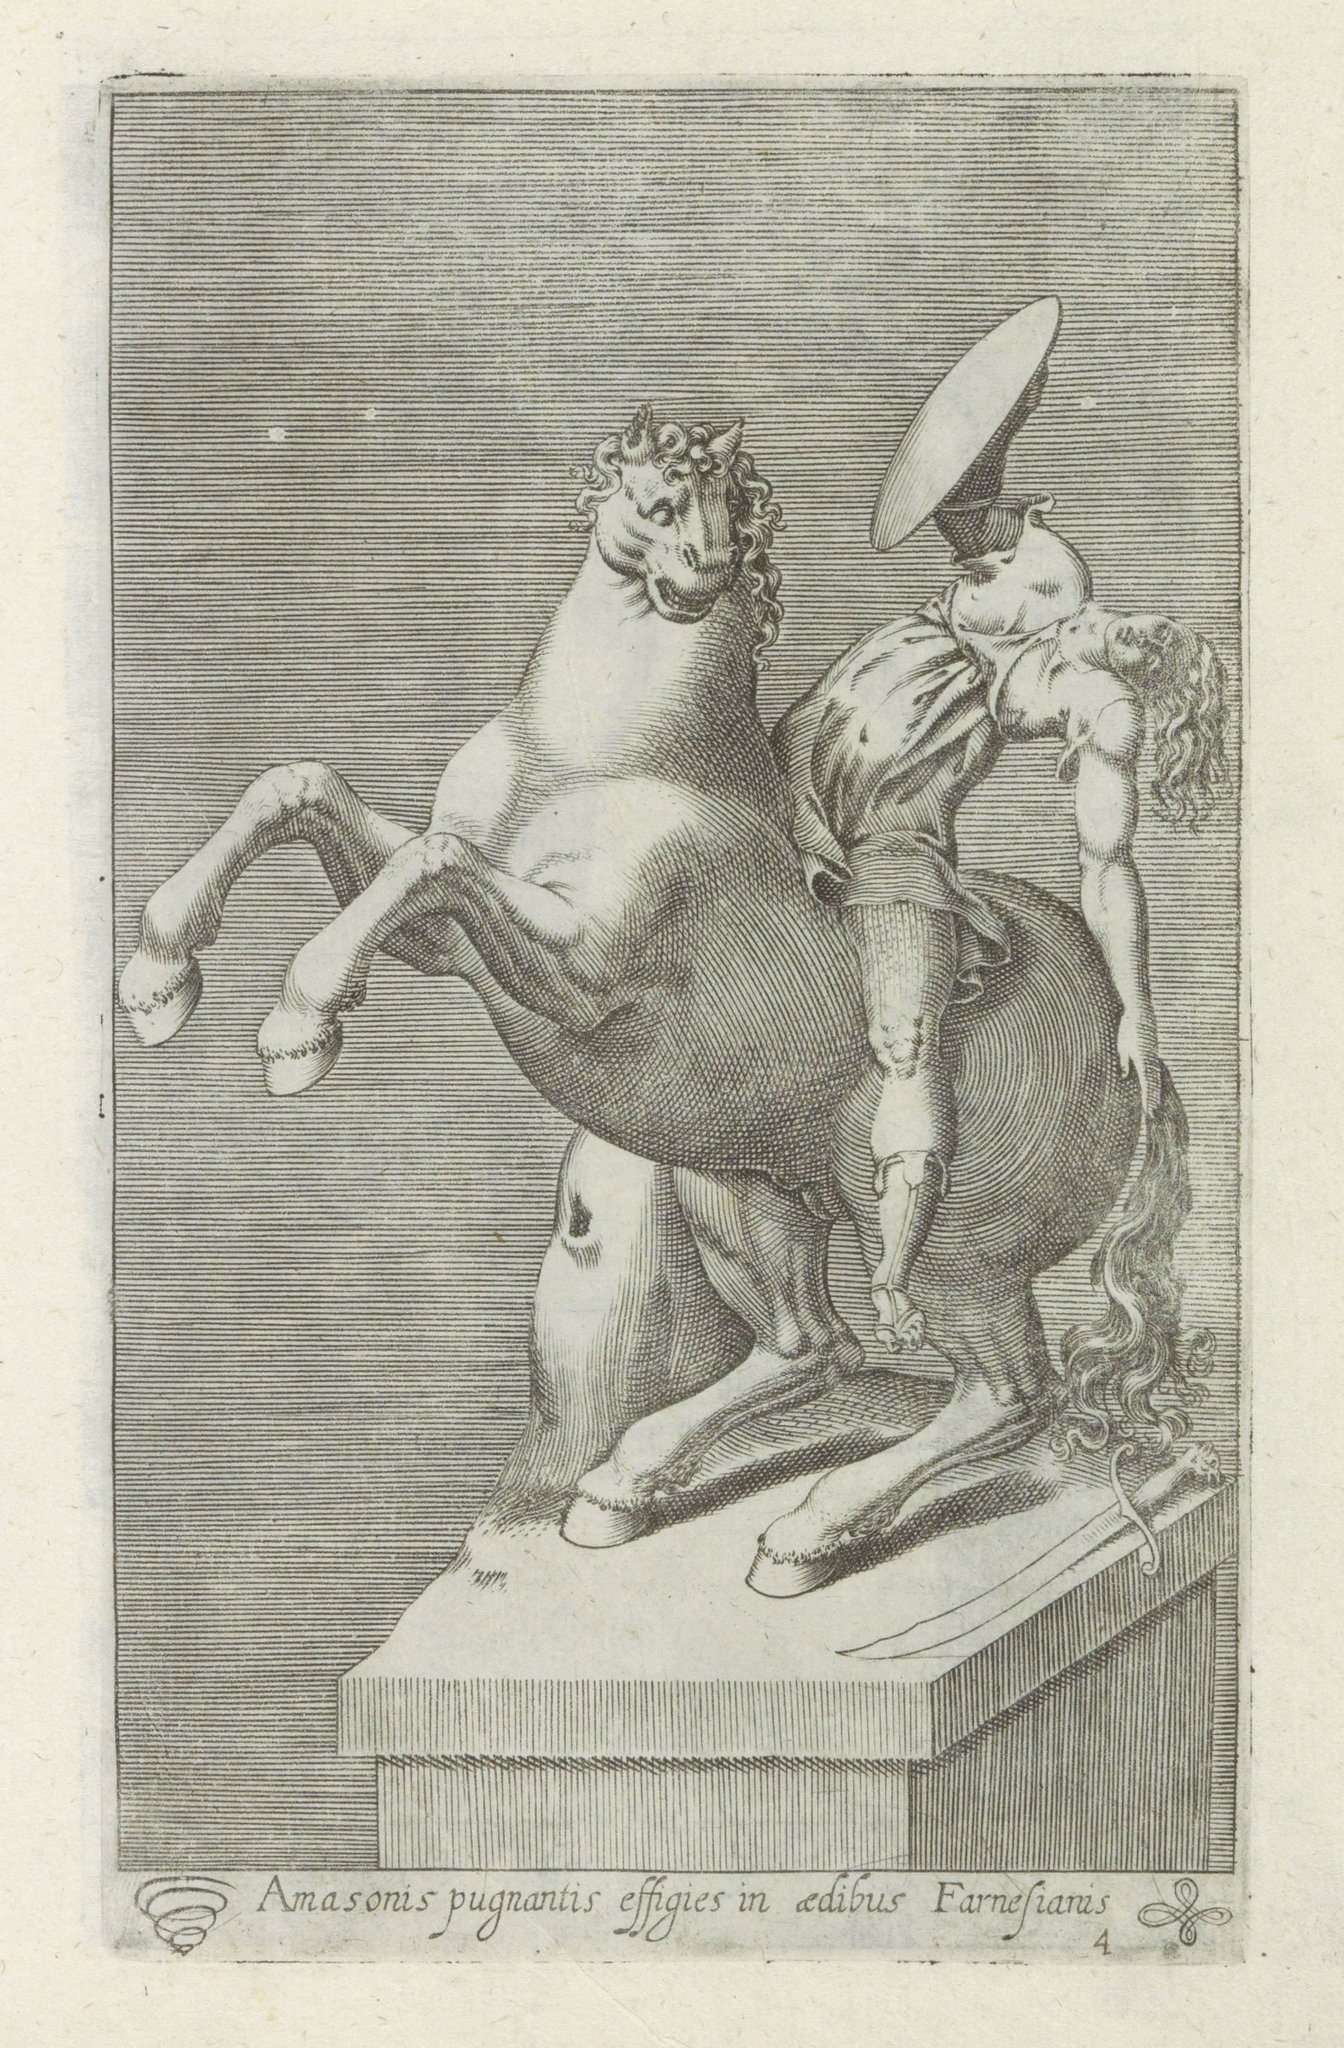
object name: print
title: Sculptuur van een Amazone te paard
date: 1584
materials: paper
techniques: engraving, intaglio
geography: rome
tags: (story of) the amazons, piece of sculpture, reproduction of a piece of sculpture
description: Het beeld bevindt zich in het Museo archeologico Nazionale di Napoli. Deze prent maakt deel uit van een set van 79 prenten (+ titelprent) met voorstellingen van antieke sculpturen in Rome.